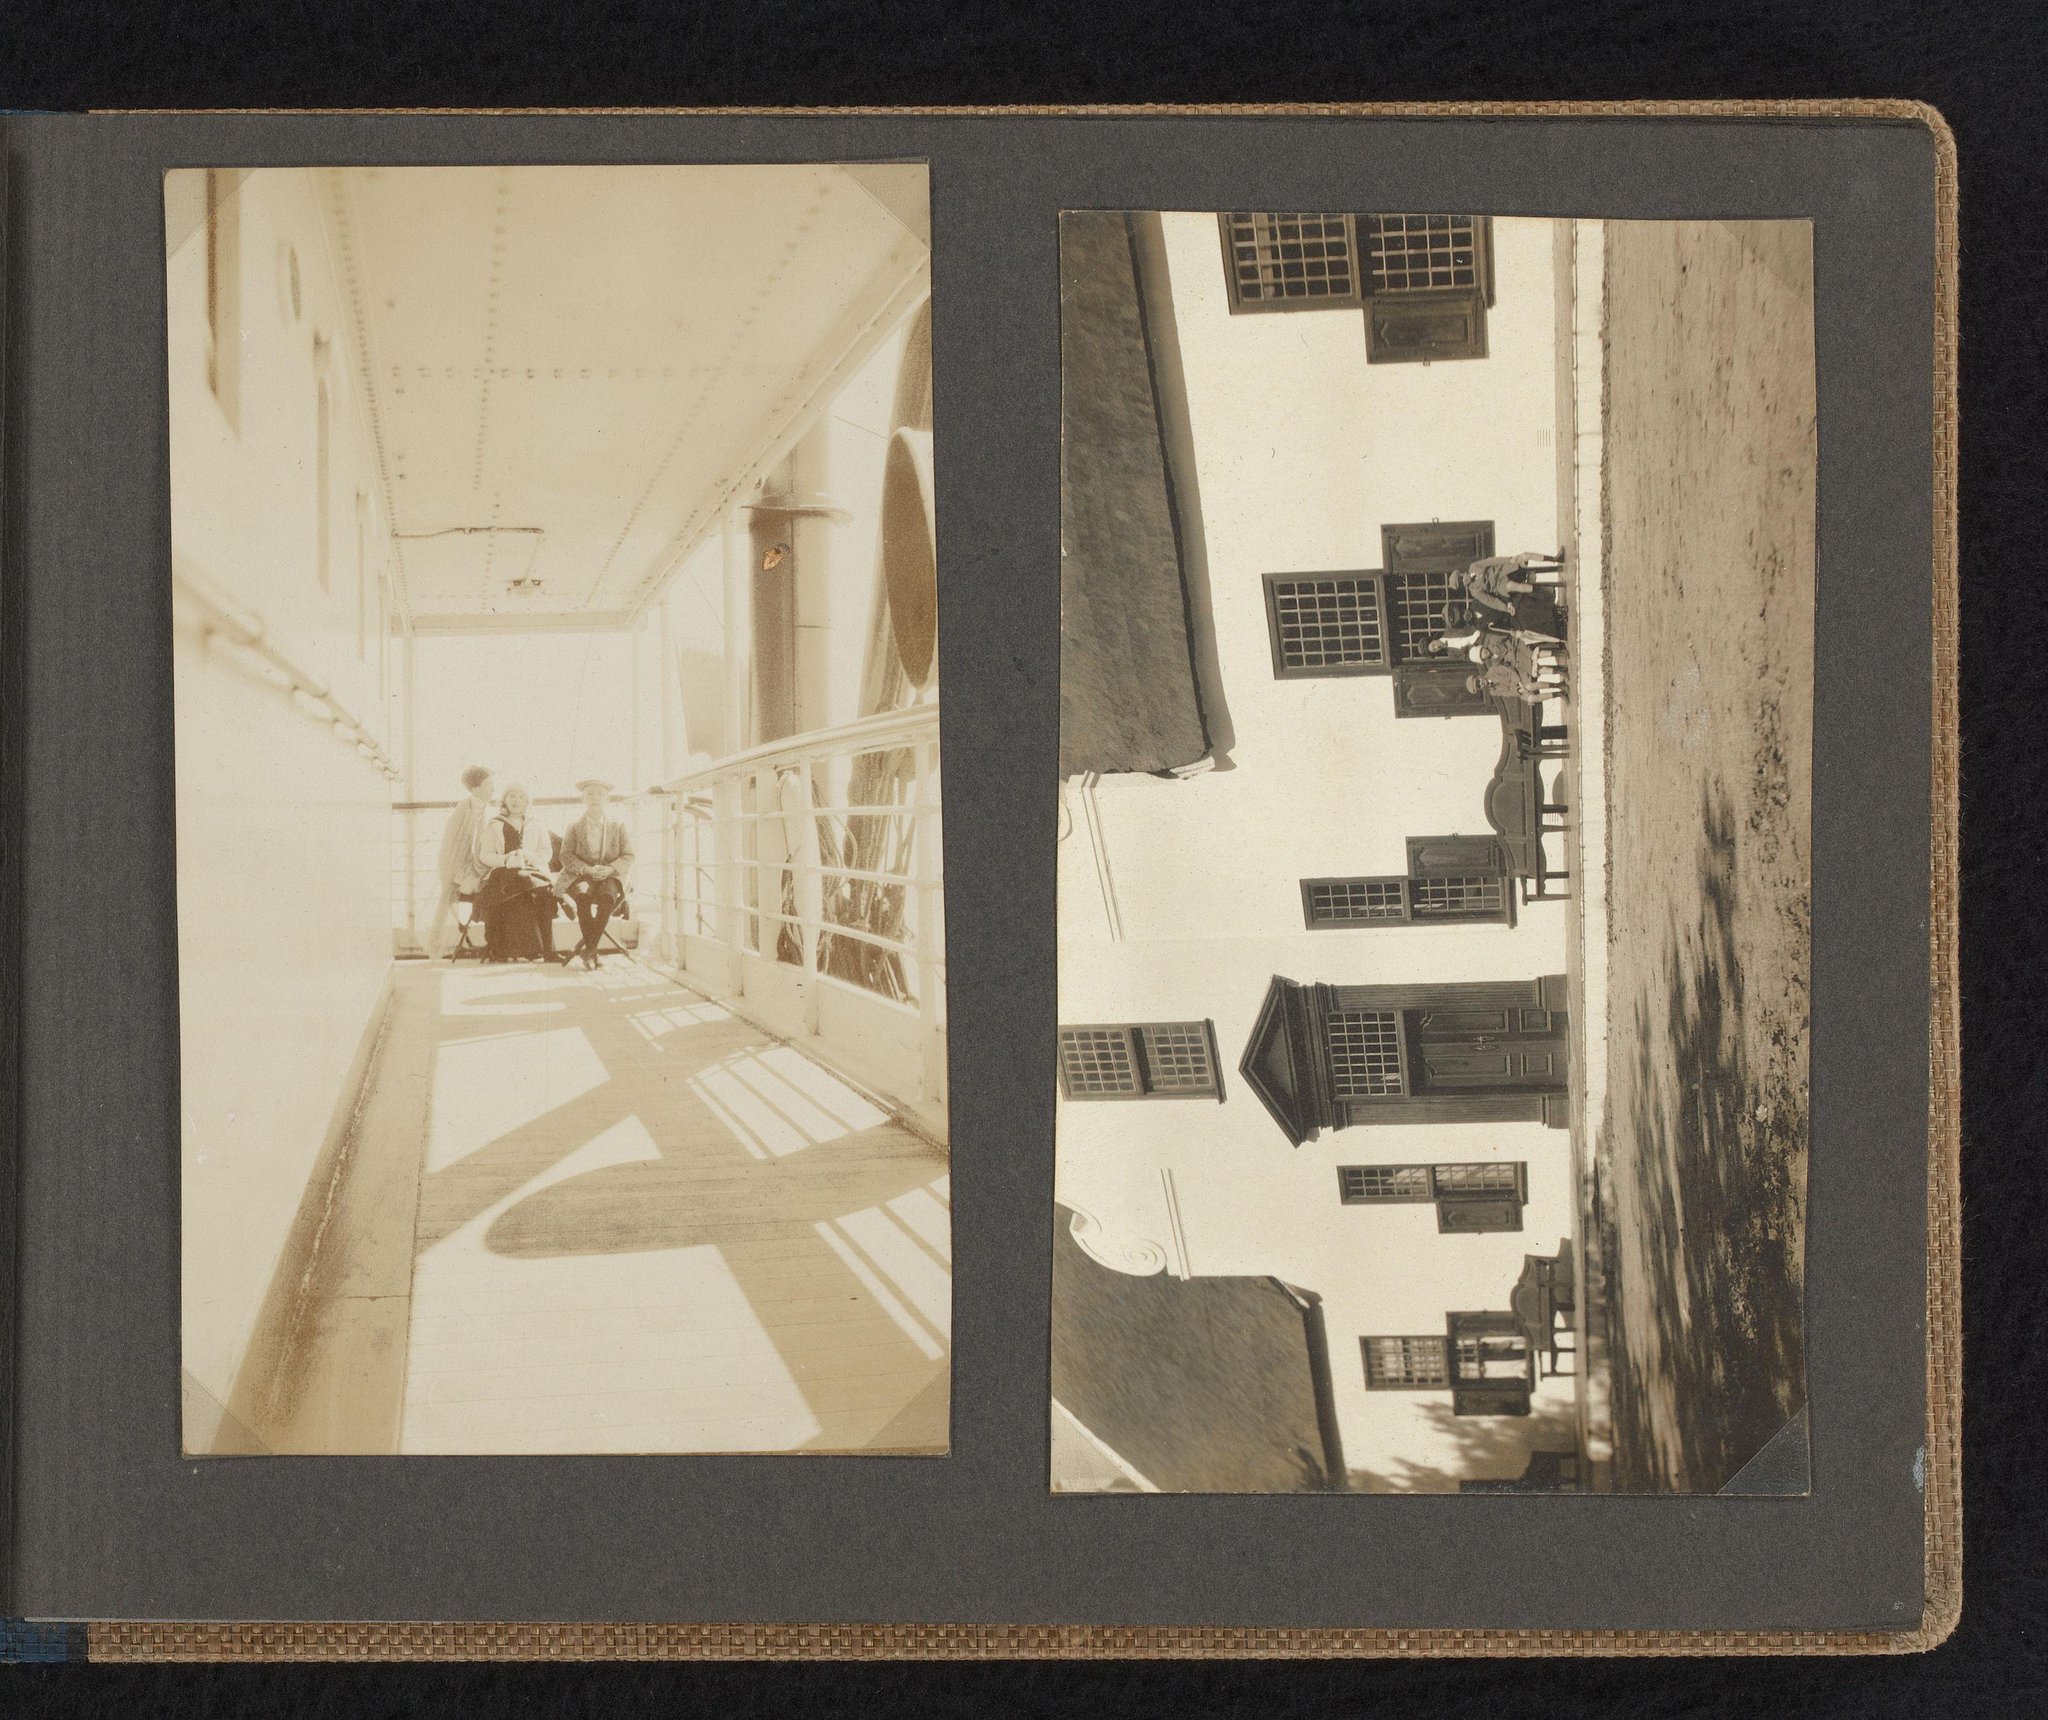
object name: album leaf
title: Gezin van Karel Frederik van den Berg op een schip en in Zuid-Afrika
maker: karel frederik van den berg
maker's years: 1873-1948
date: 1910-1913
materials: paper, cardboard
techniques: gelatin silver print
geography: south africa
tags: amsterdam, norbert van den berg (1901-1972), batavia, karel frederik van den berg, willem jacob van den berg, caroline frederique van den berg, arendina charlotte marie van den berg-geertsema, ships (in general), family life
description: Deze foto's zijn onderdeel van een album.